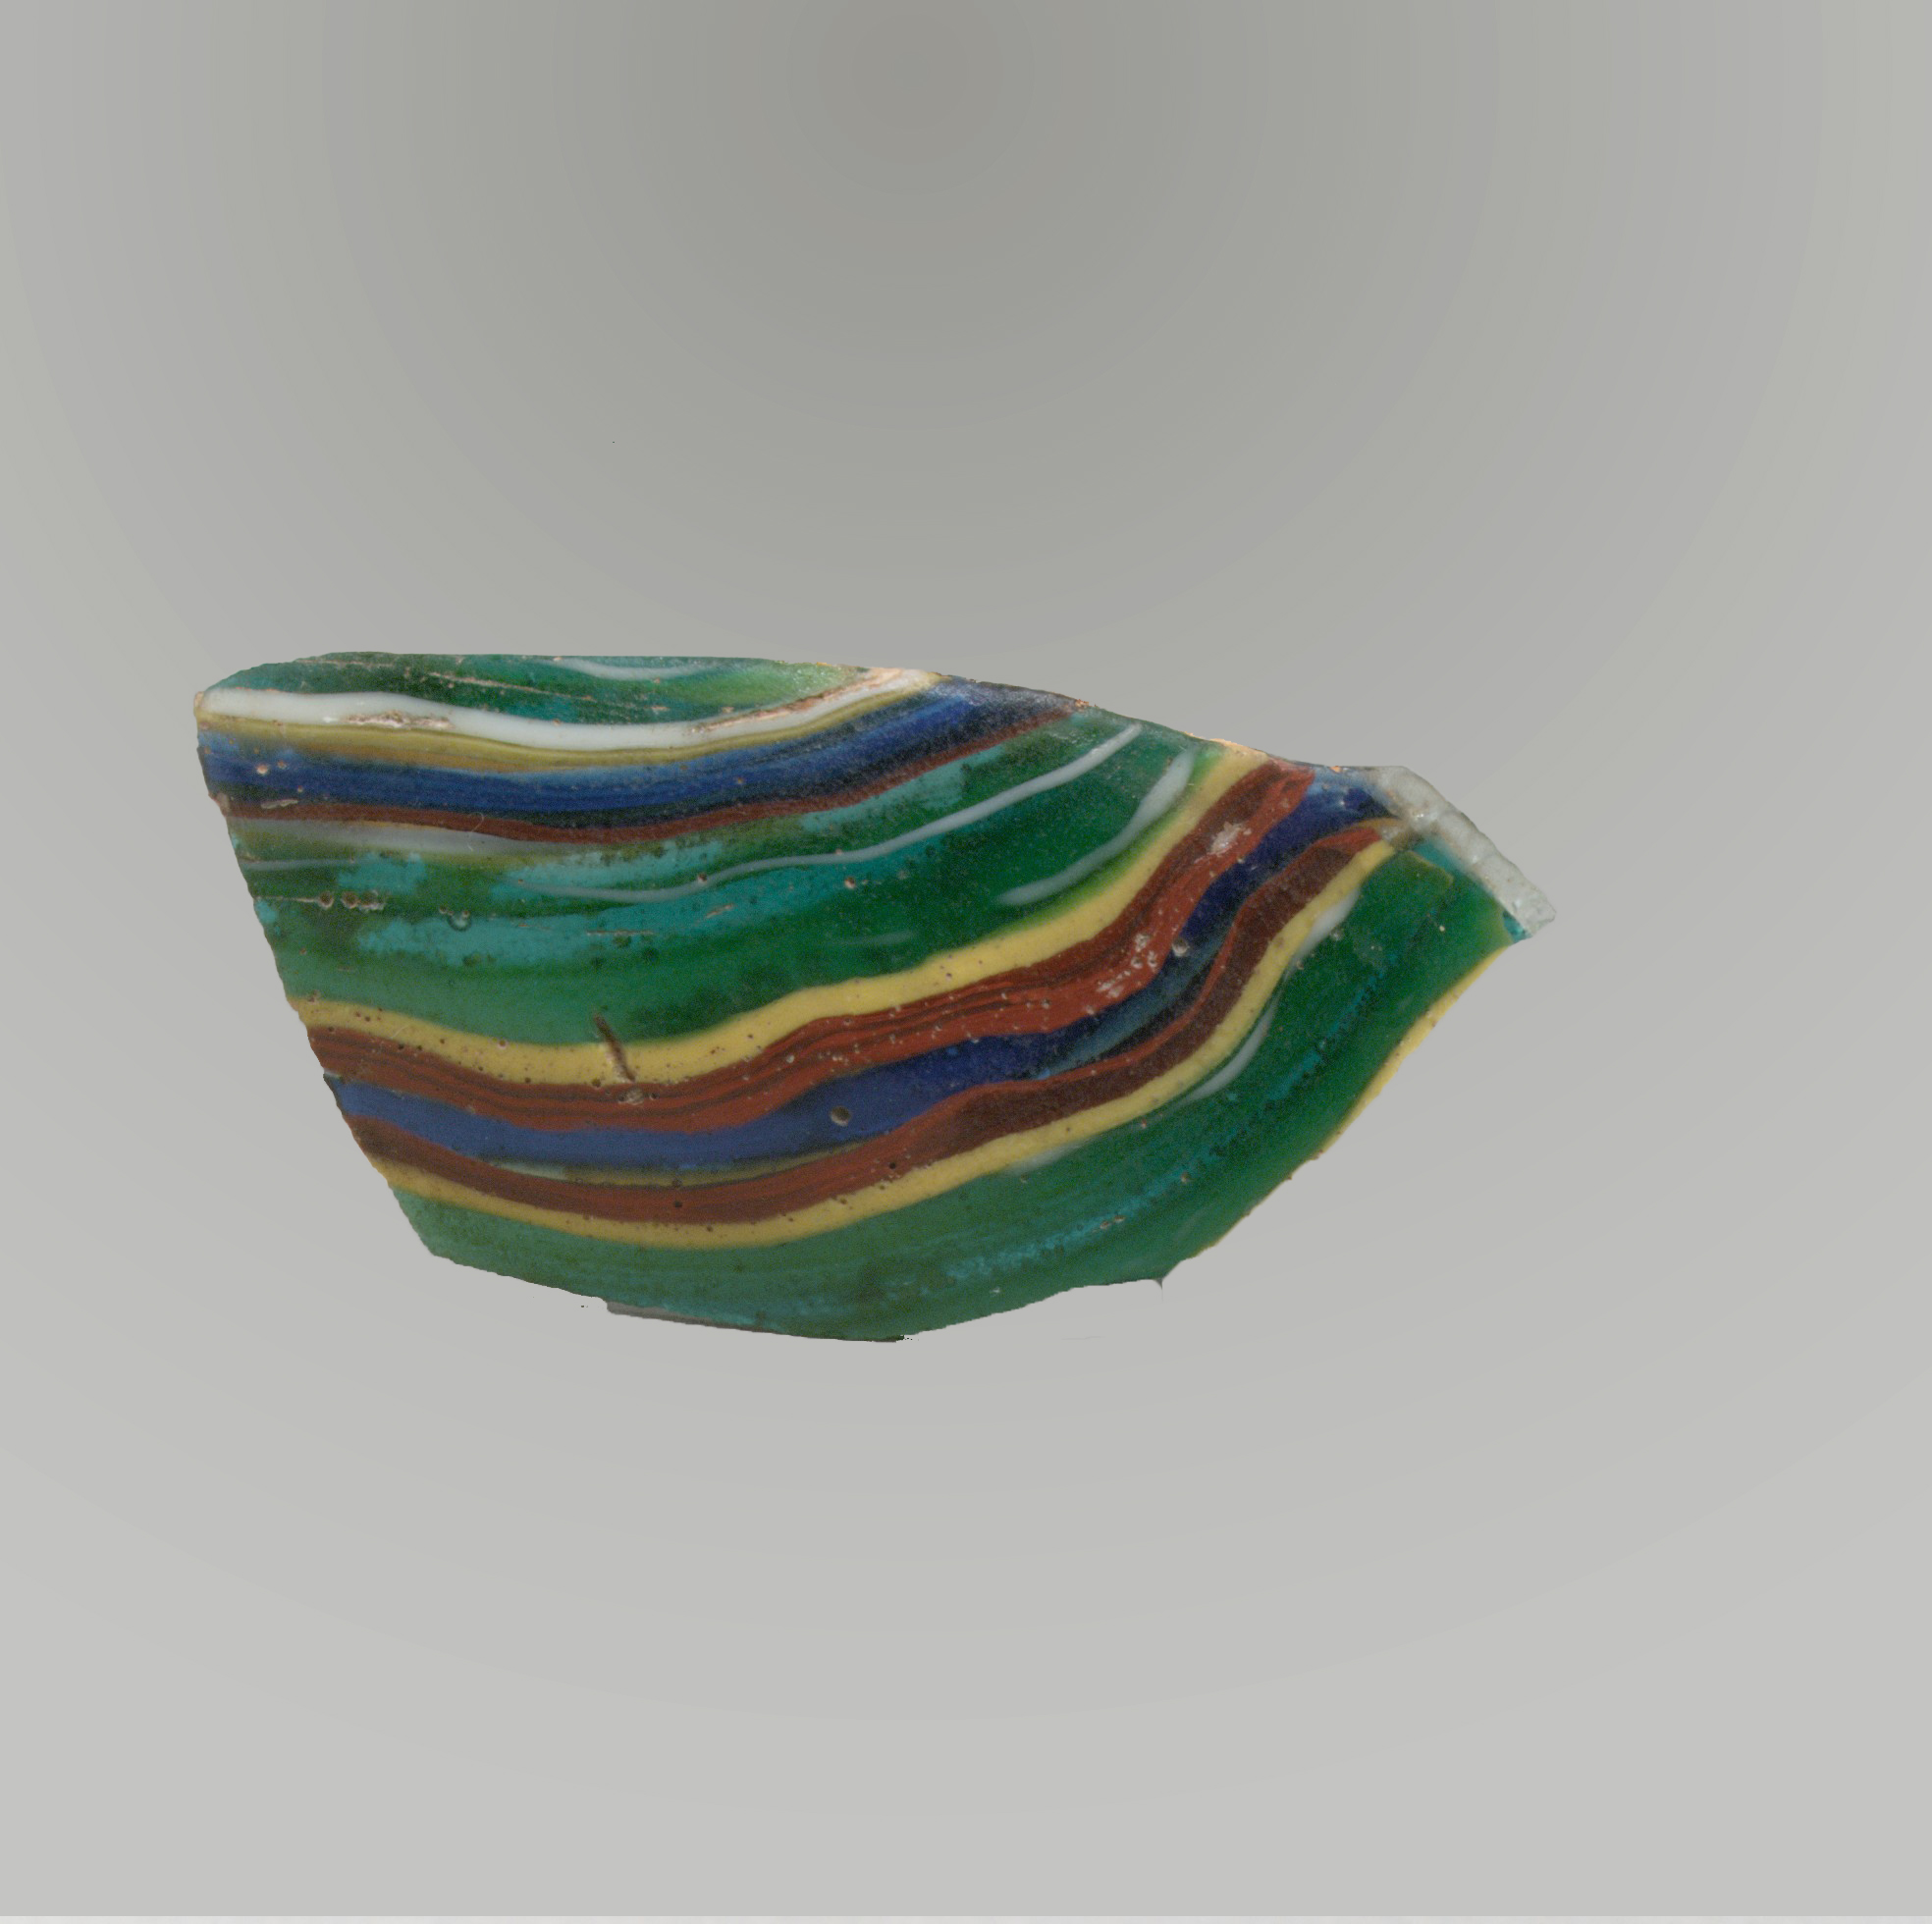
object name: fragment, striped mosaic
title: Glass striped mosaic bowl fragment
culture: roman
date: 34 BCE-33 CE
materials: glass